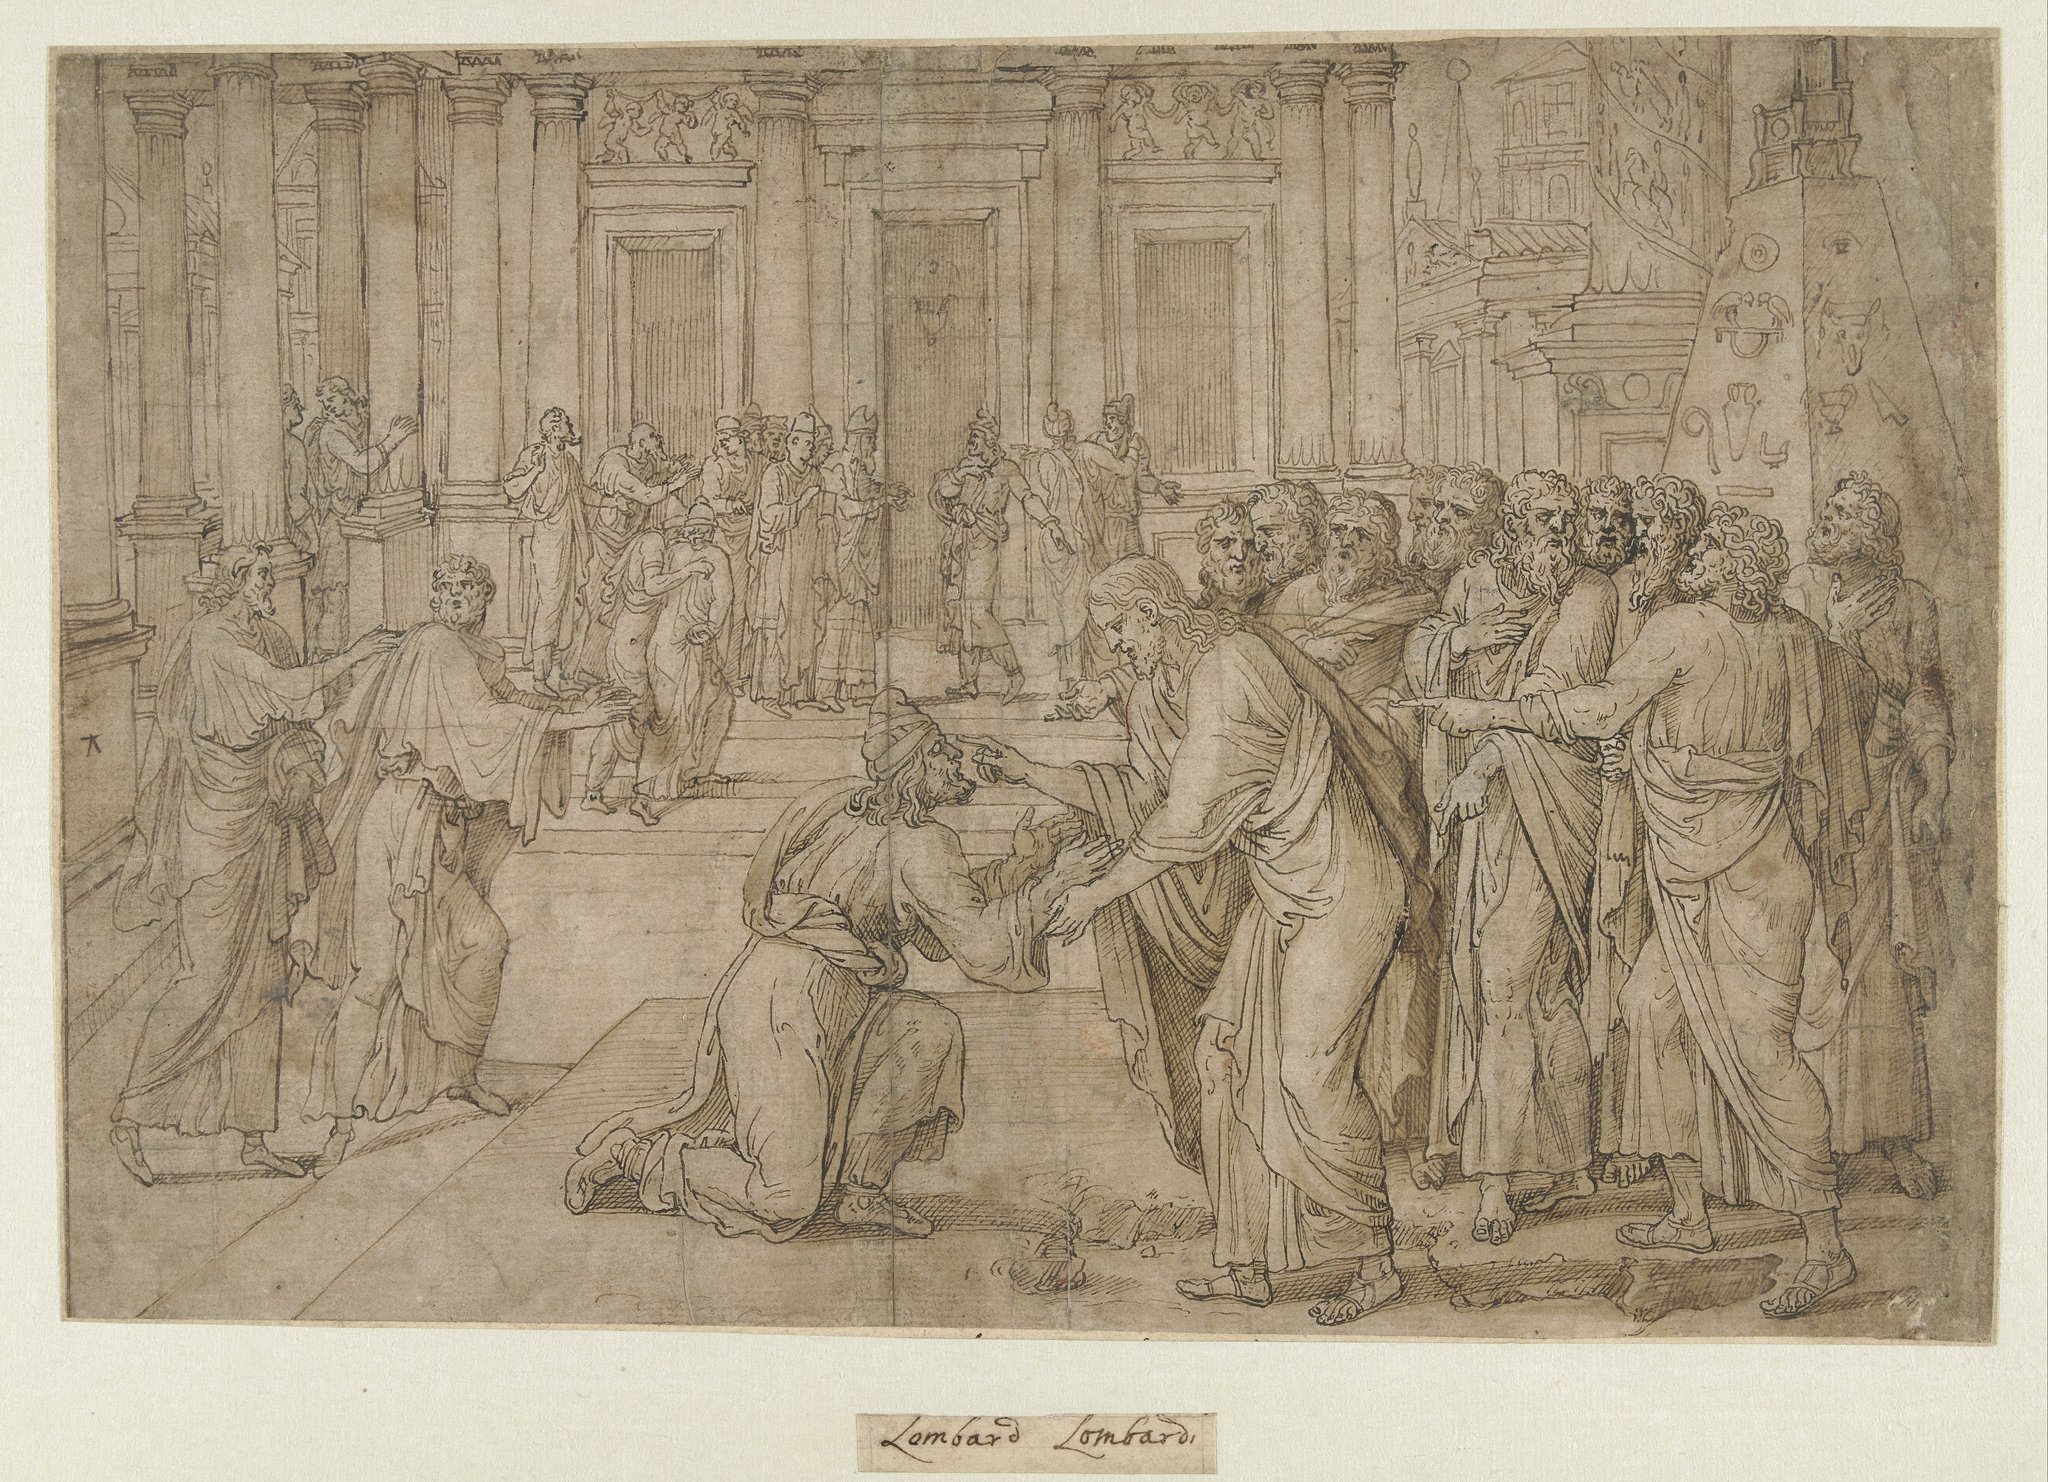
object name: drawing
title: Christus geneest een blinde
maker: lambert lombard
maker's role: draughtsman, print maker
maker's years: 1505-1566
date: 1515-1566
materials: ink, paper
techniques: brush, pen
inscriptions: signature: ‘op een apart strookje papier:"Lombard Lombard" (pen in bruin)’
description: Christus geneest een blinde (Matt. 9: 27-31). Rechts van de Christusfiguur heeft de kunstenaar een deel van het papier weggesneden, een nieuw stuk papier aangebracht en daarop correcties uitgevoerd.